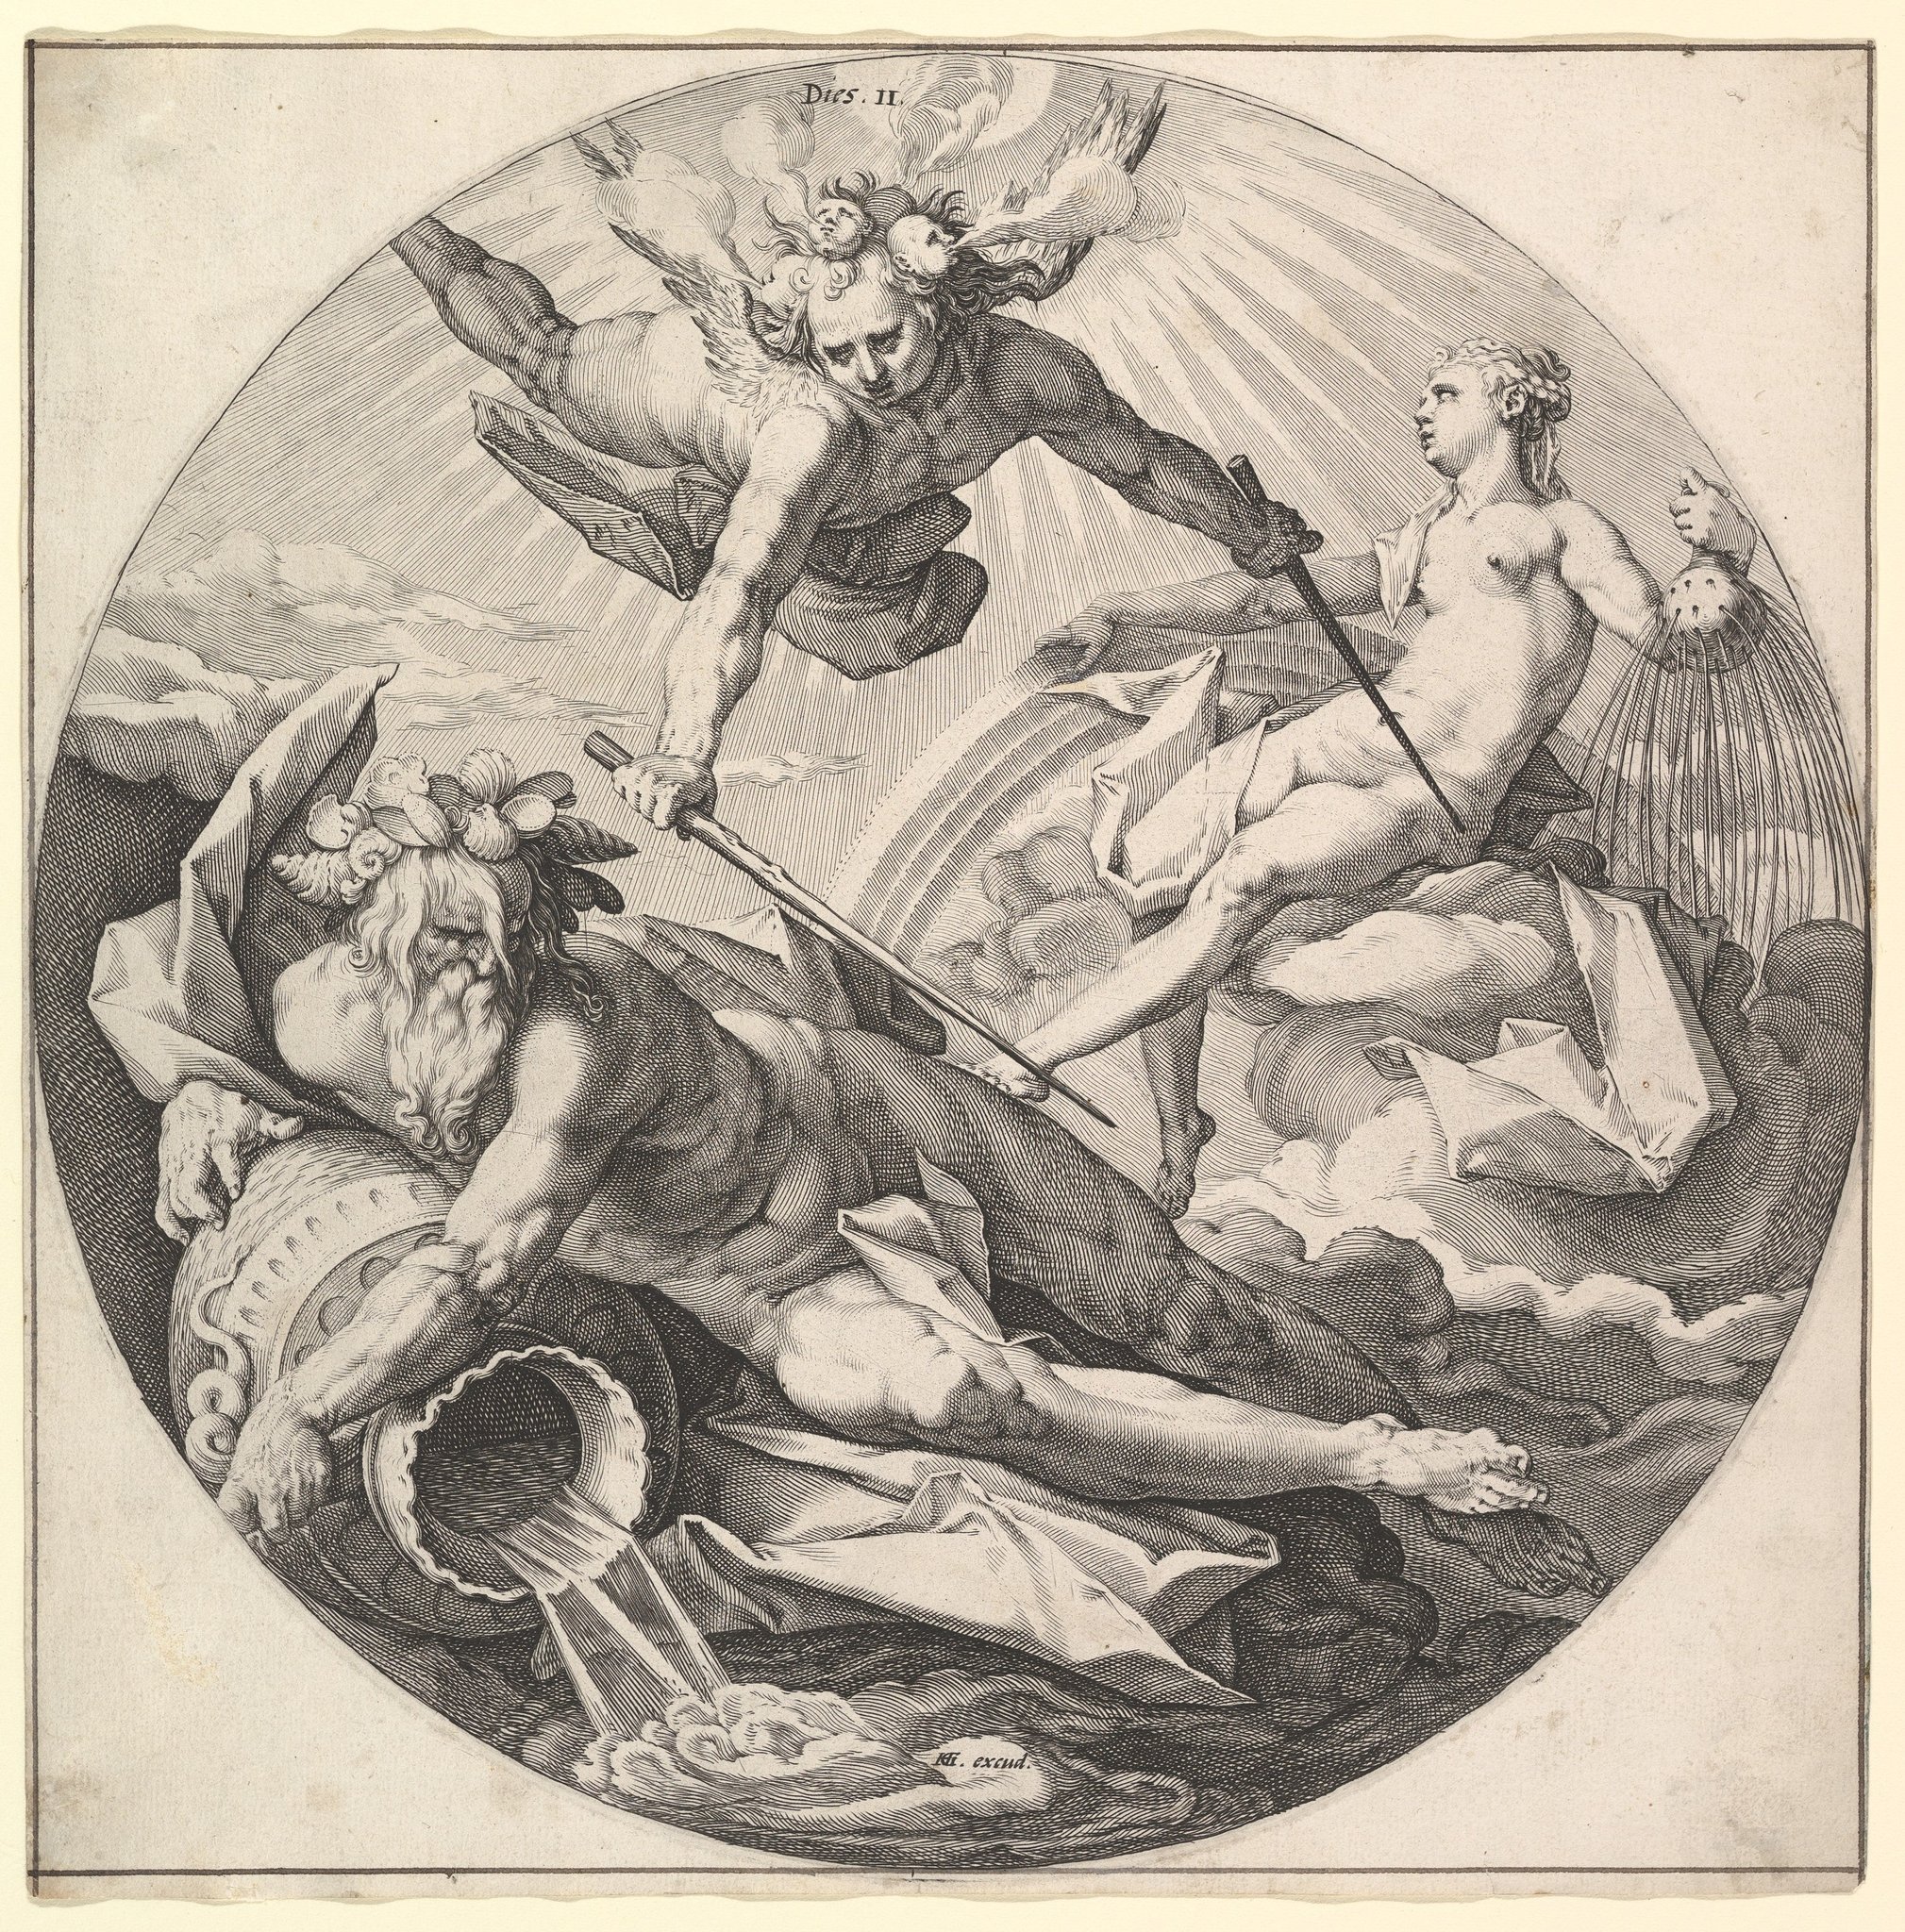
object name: print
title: The Second Day (Dies II): The Division of the Waters, plate 2 from "The Creation of the World"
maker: jan muller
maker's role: artist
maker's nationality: netherlandish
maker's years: 1571-1628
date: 1589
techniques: engraving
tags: adam,eve